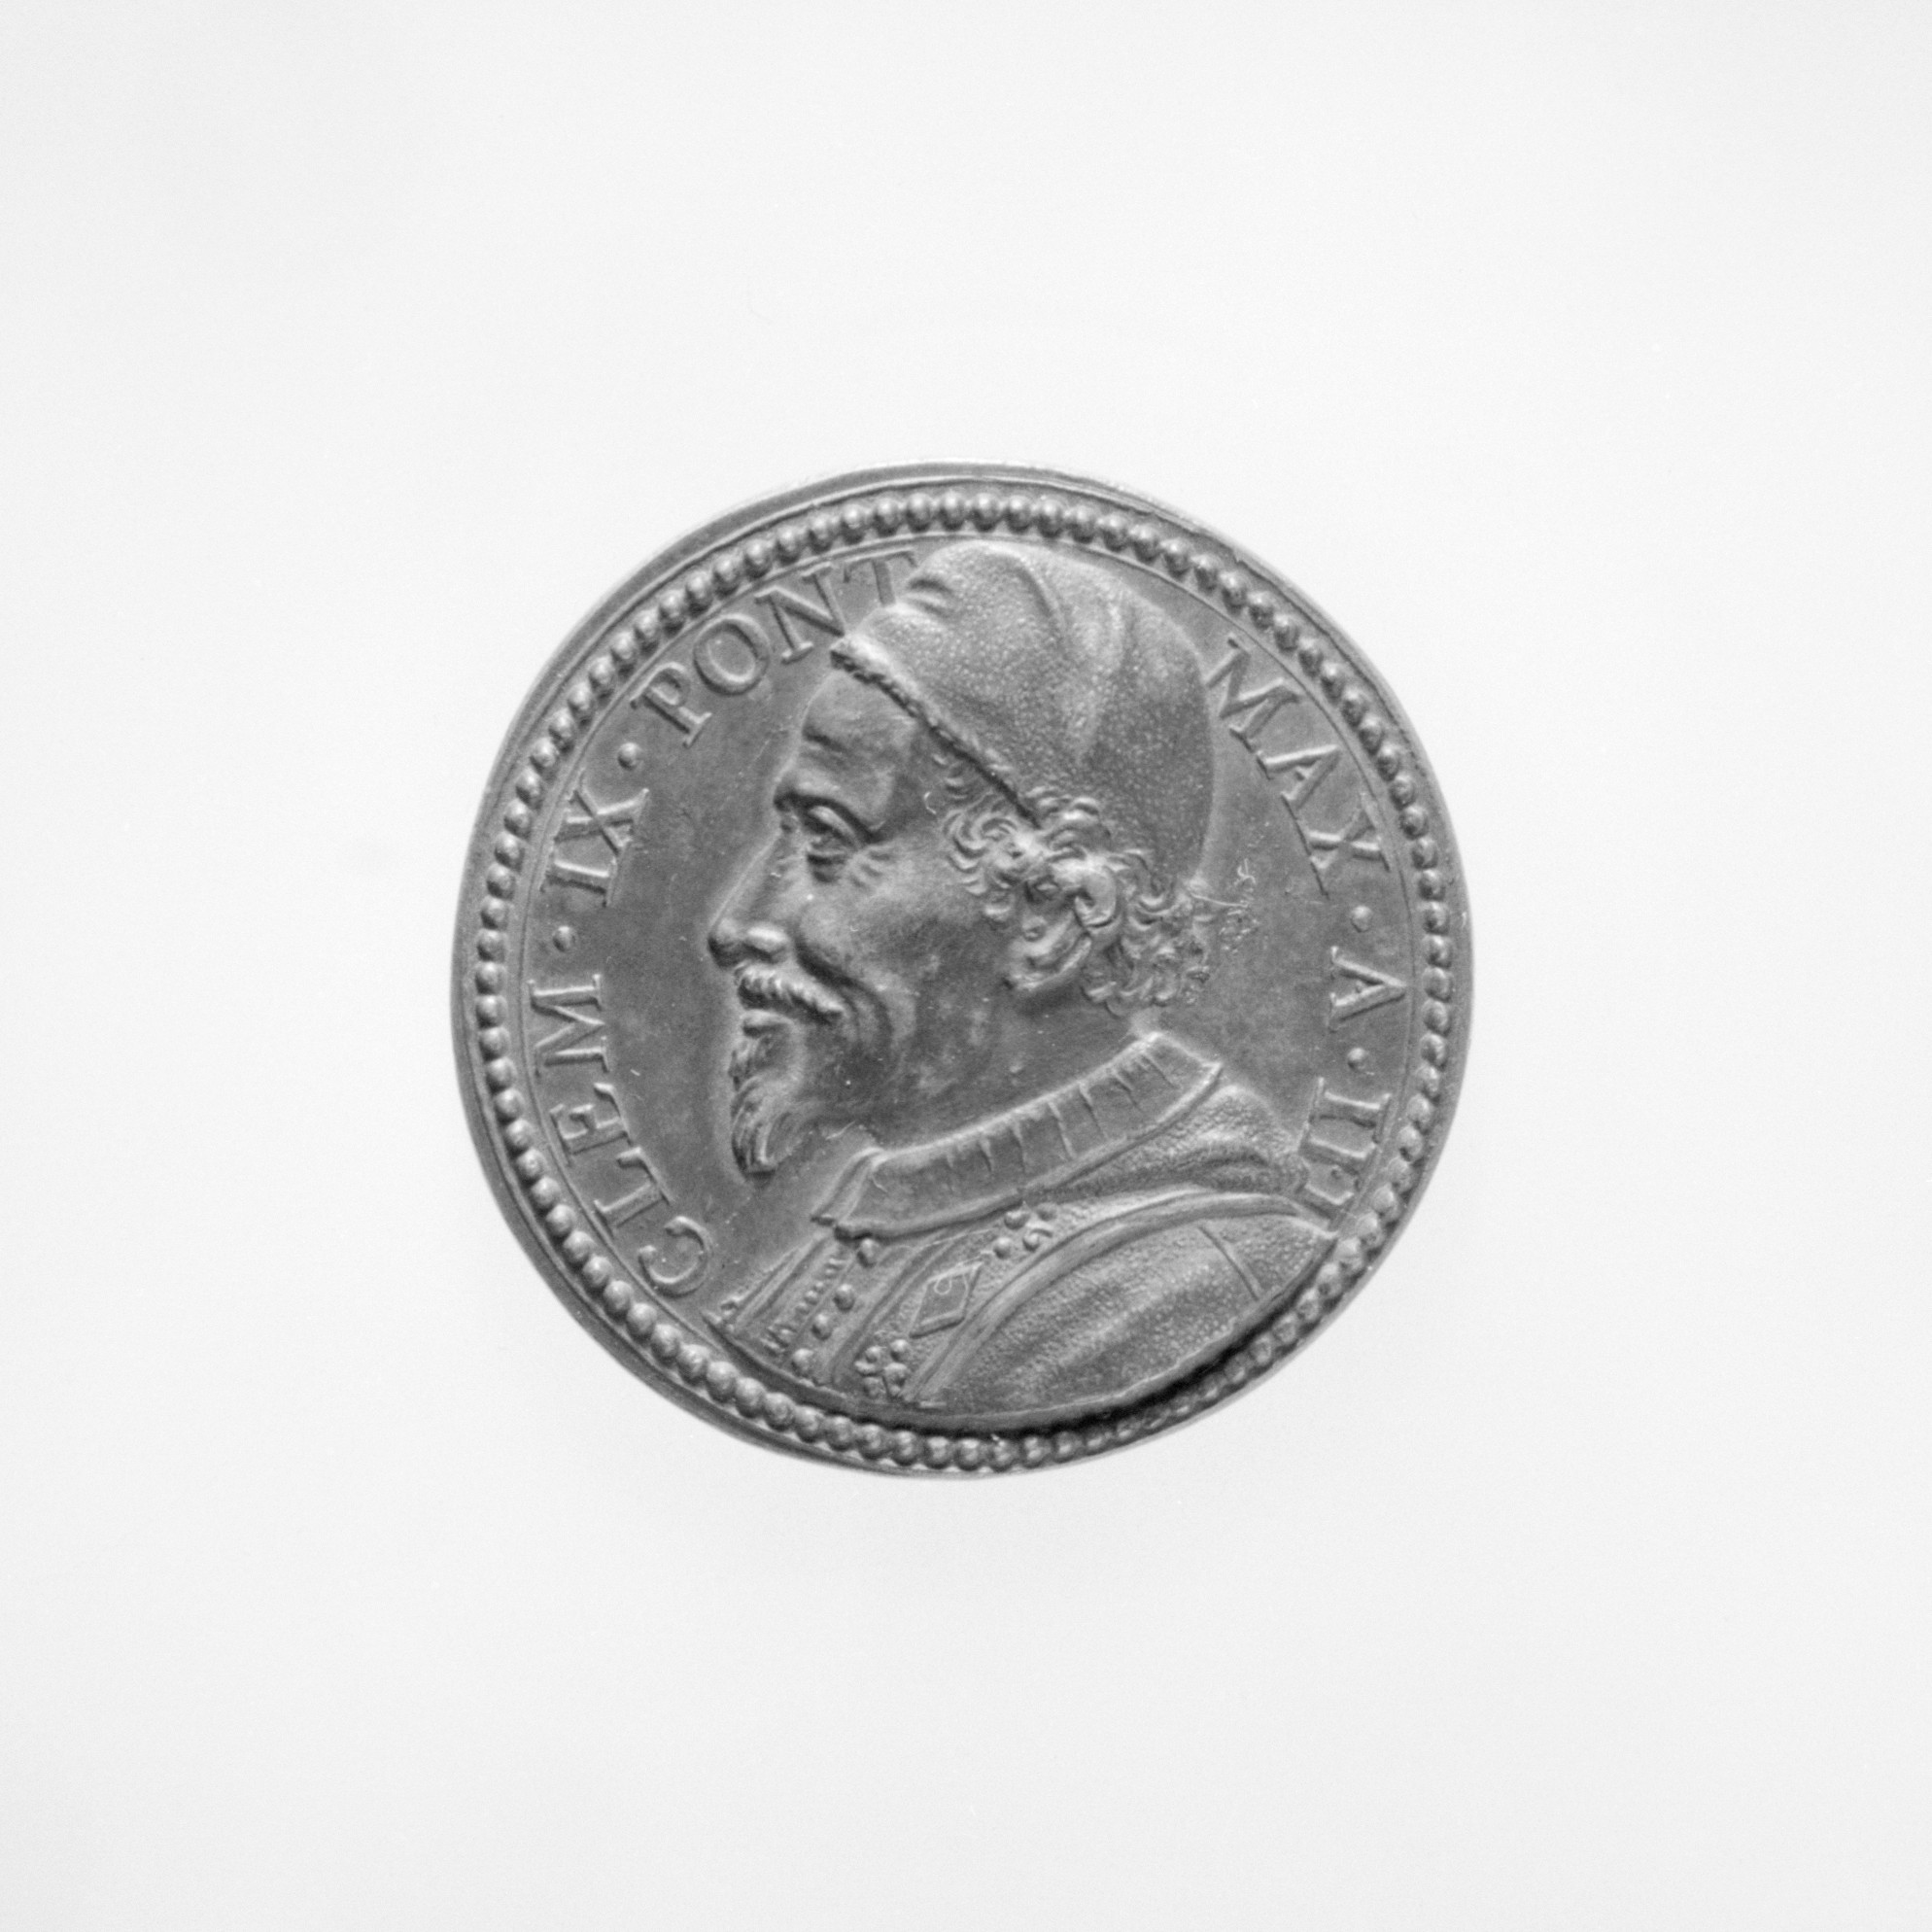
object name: medal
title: Clement IX (Pope, 1667–69)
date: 1669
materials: bronze, patina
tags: men,profiles,popes